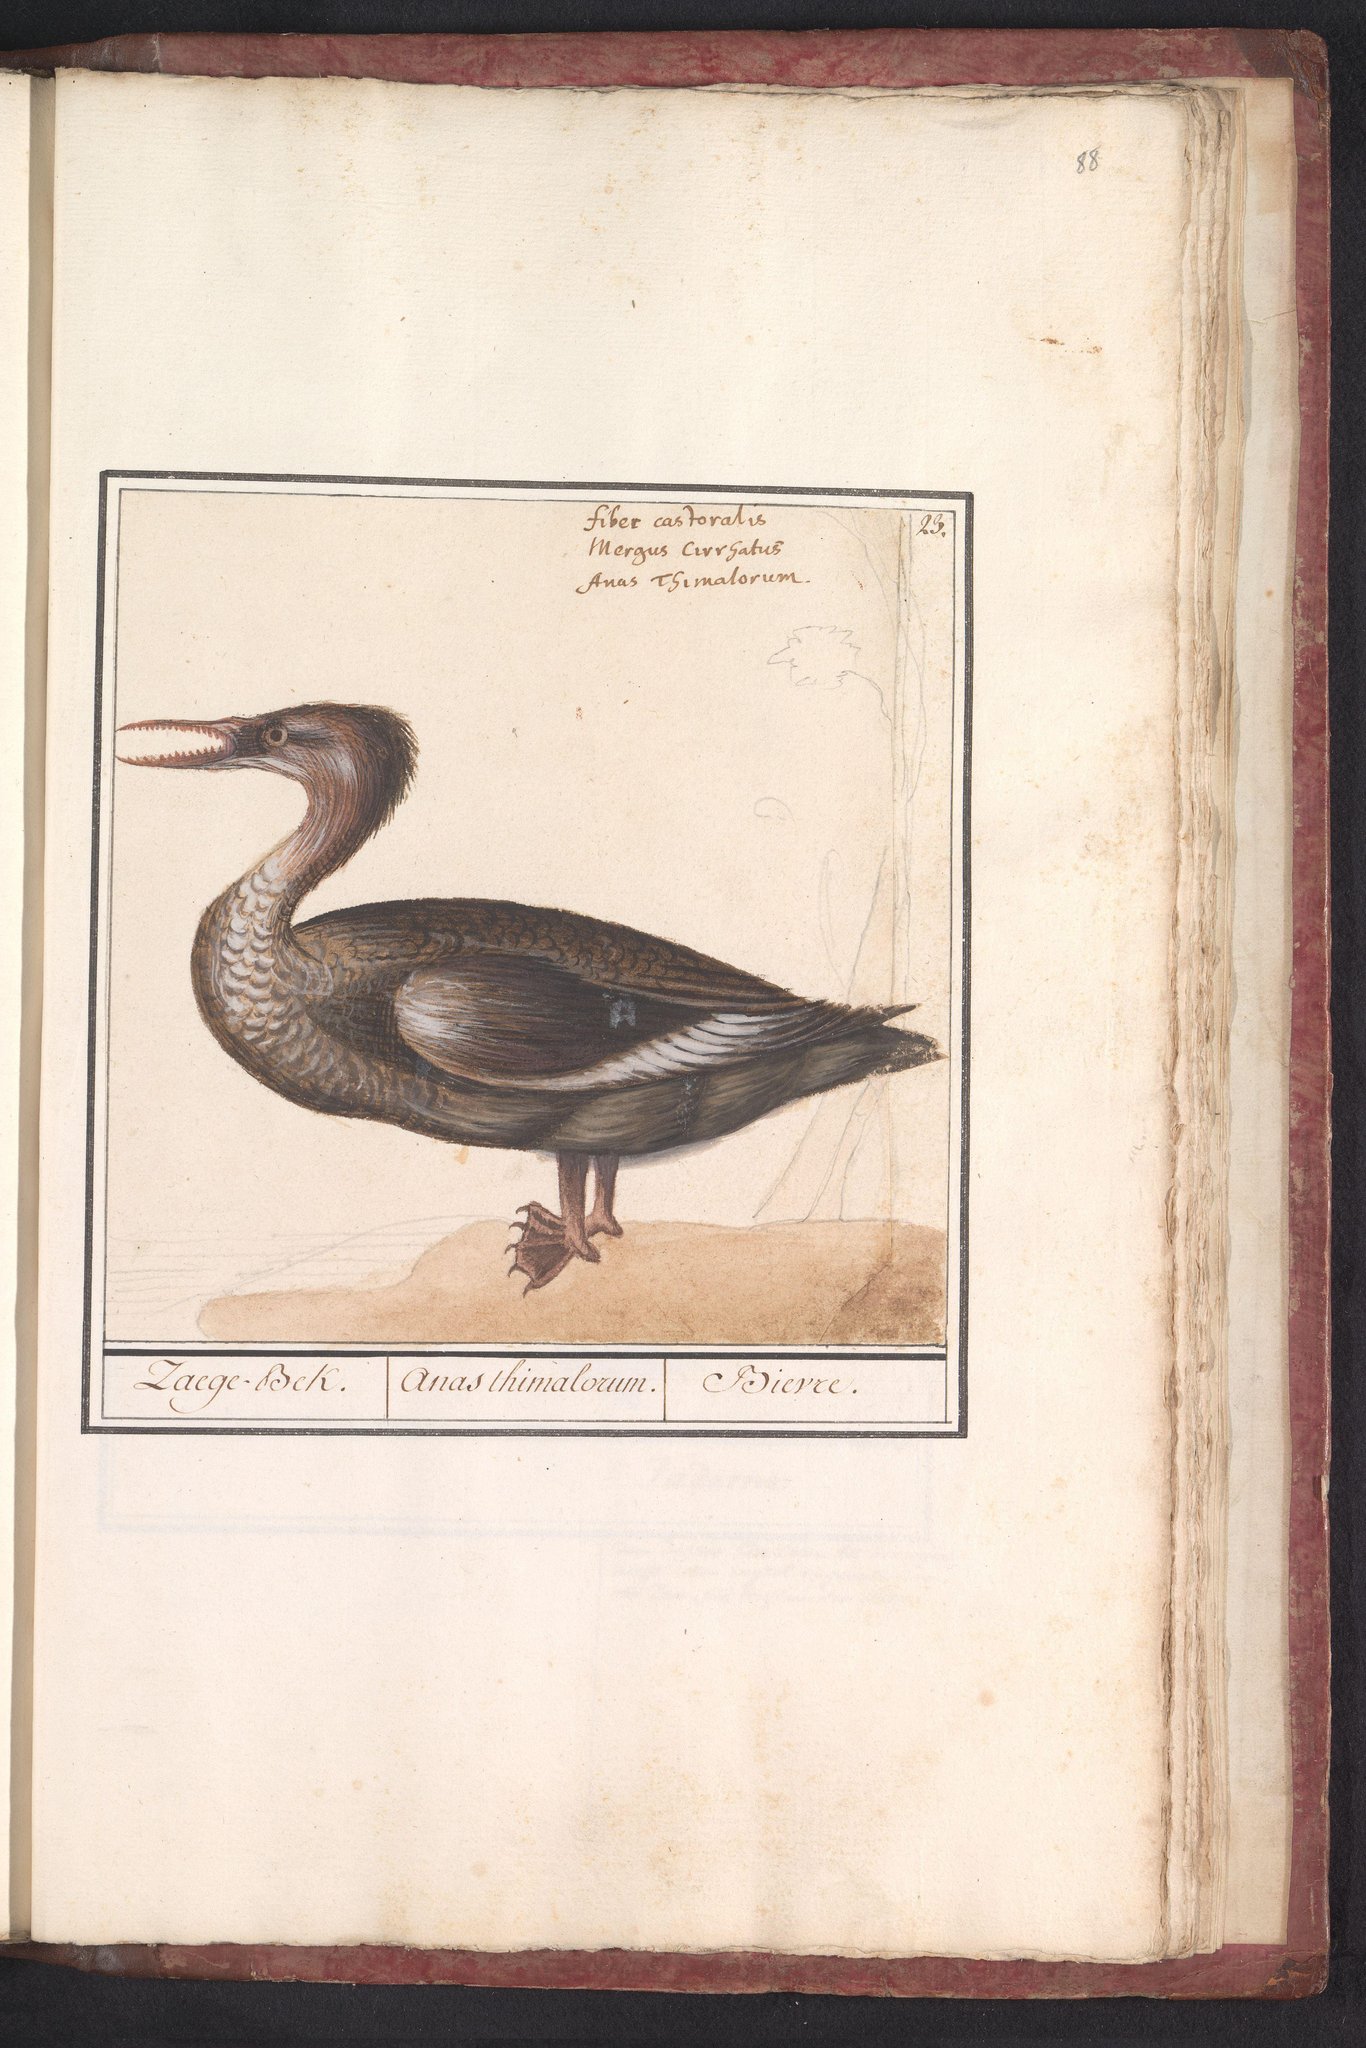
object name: drawing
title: Grote zaagbek (Mergus merganser)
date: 1596-1610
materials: chalk, paint, ink, paper, pencil, watercolor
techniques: brush, pen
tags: water-birds: common merganser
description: Grote of middelste zaagbek (vrouwtje). Genummerd rechtsboven: 23. Hier ook de Latijnse namen. Onderdeel van het derde album met tekeningen van vogels. Vijfde van twaalf albums met tekeningen van dieren, vogels en planten bekend rond 1600, gemaakt in opdracht van keizer Rudolf II. Met toelichting in Nederlands, Latijn en Frans.